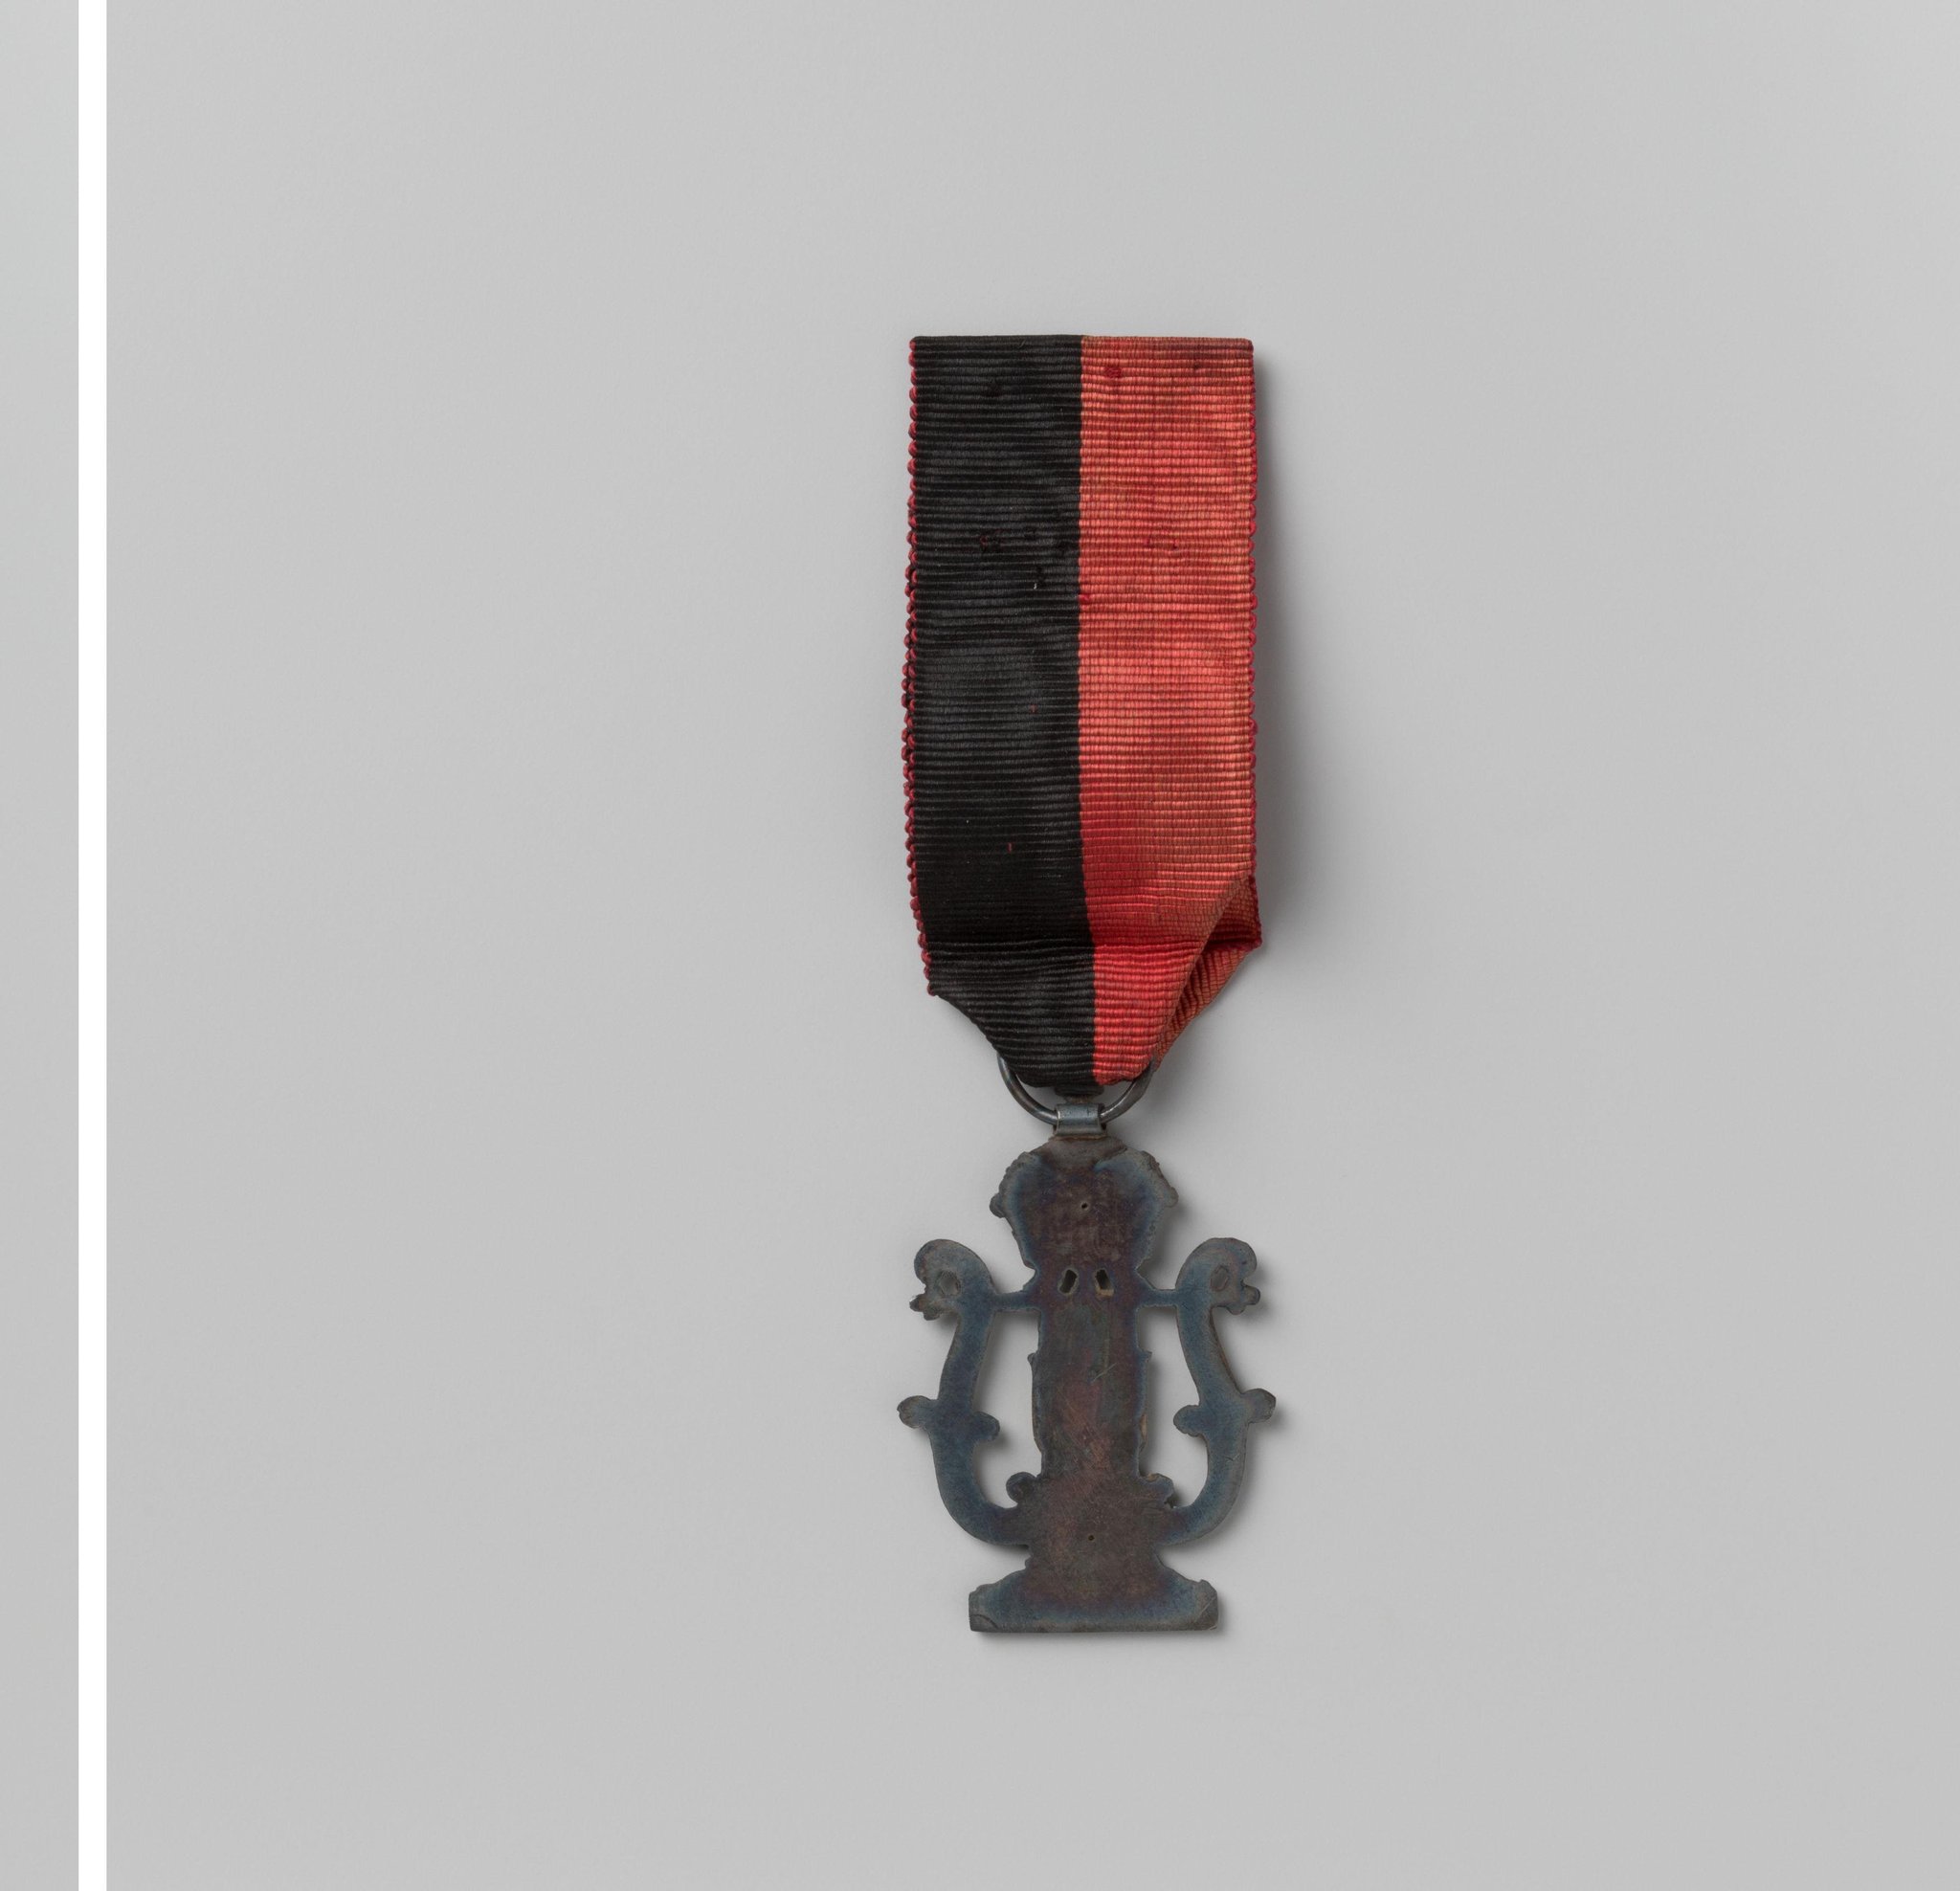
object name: insignia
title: Muziekvereniging te Amsterdam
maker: Anonymous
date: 1845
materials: silver, textile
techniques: striking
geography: amsterdam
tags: amsterdam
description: eenzijdig insigne, opgebouwd uit lier onder kroon aan draagoog, draagring en lint met rode en zwarte verticale baan; op lier: geemailleerd wapenschild